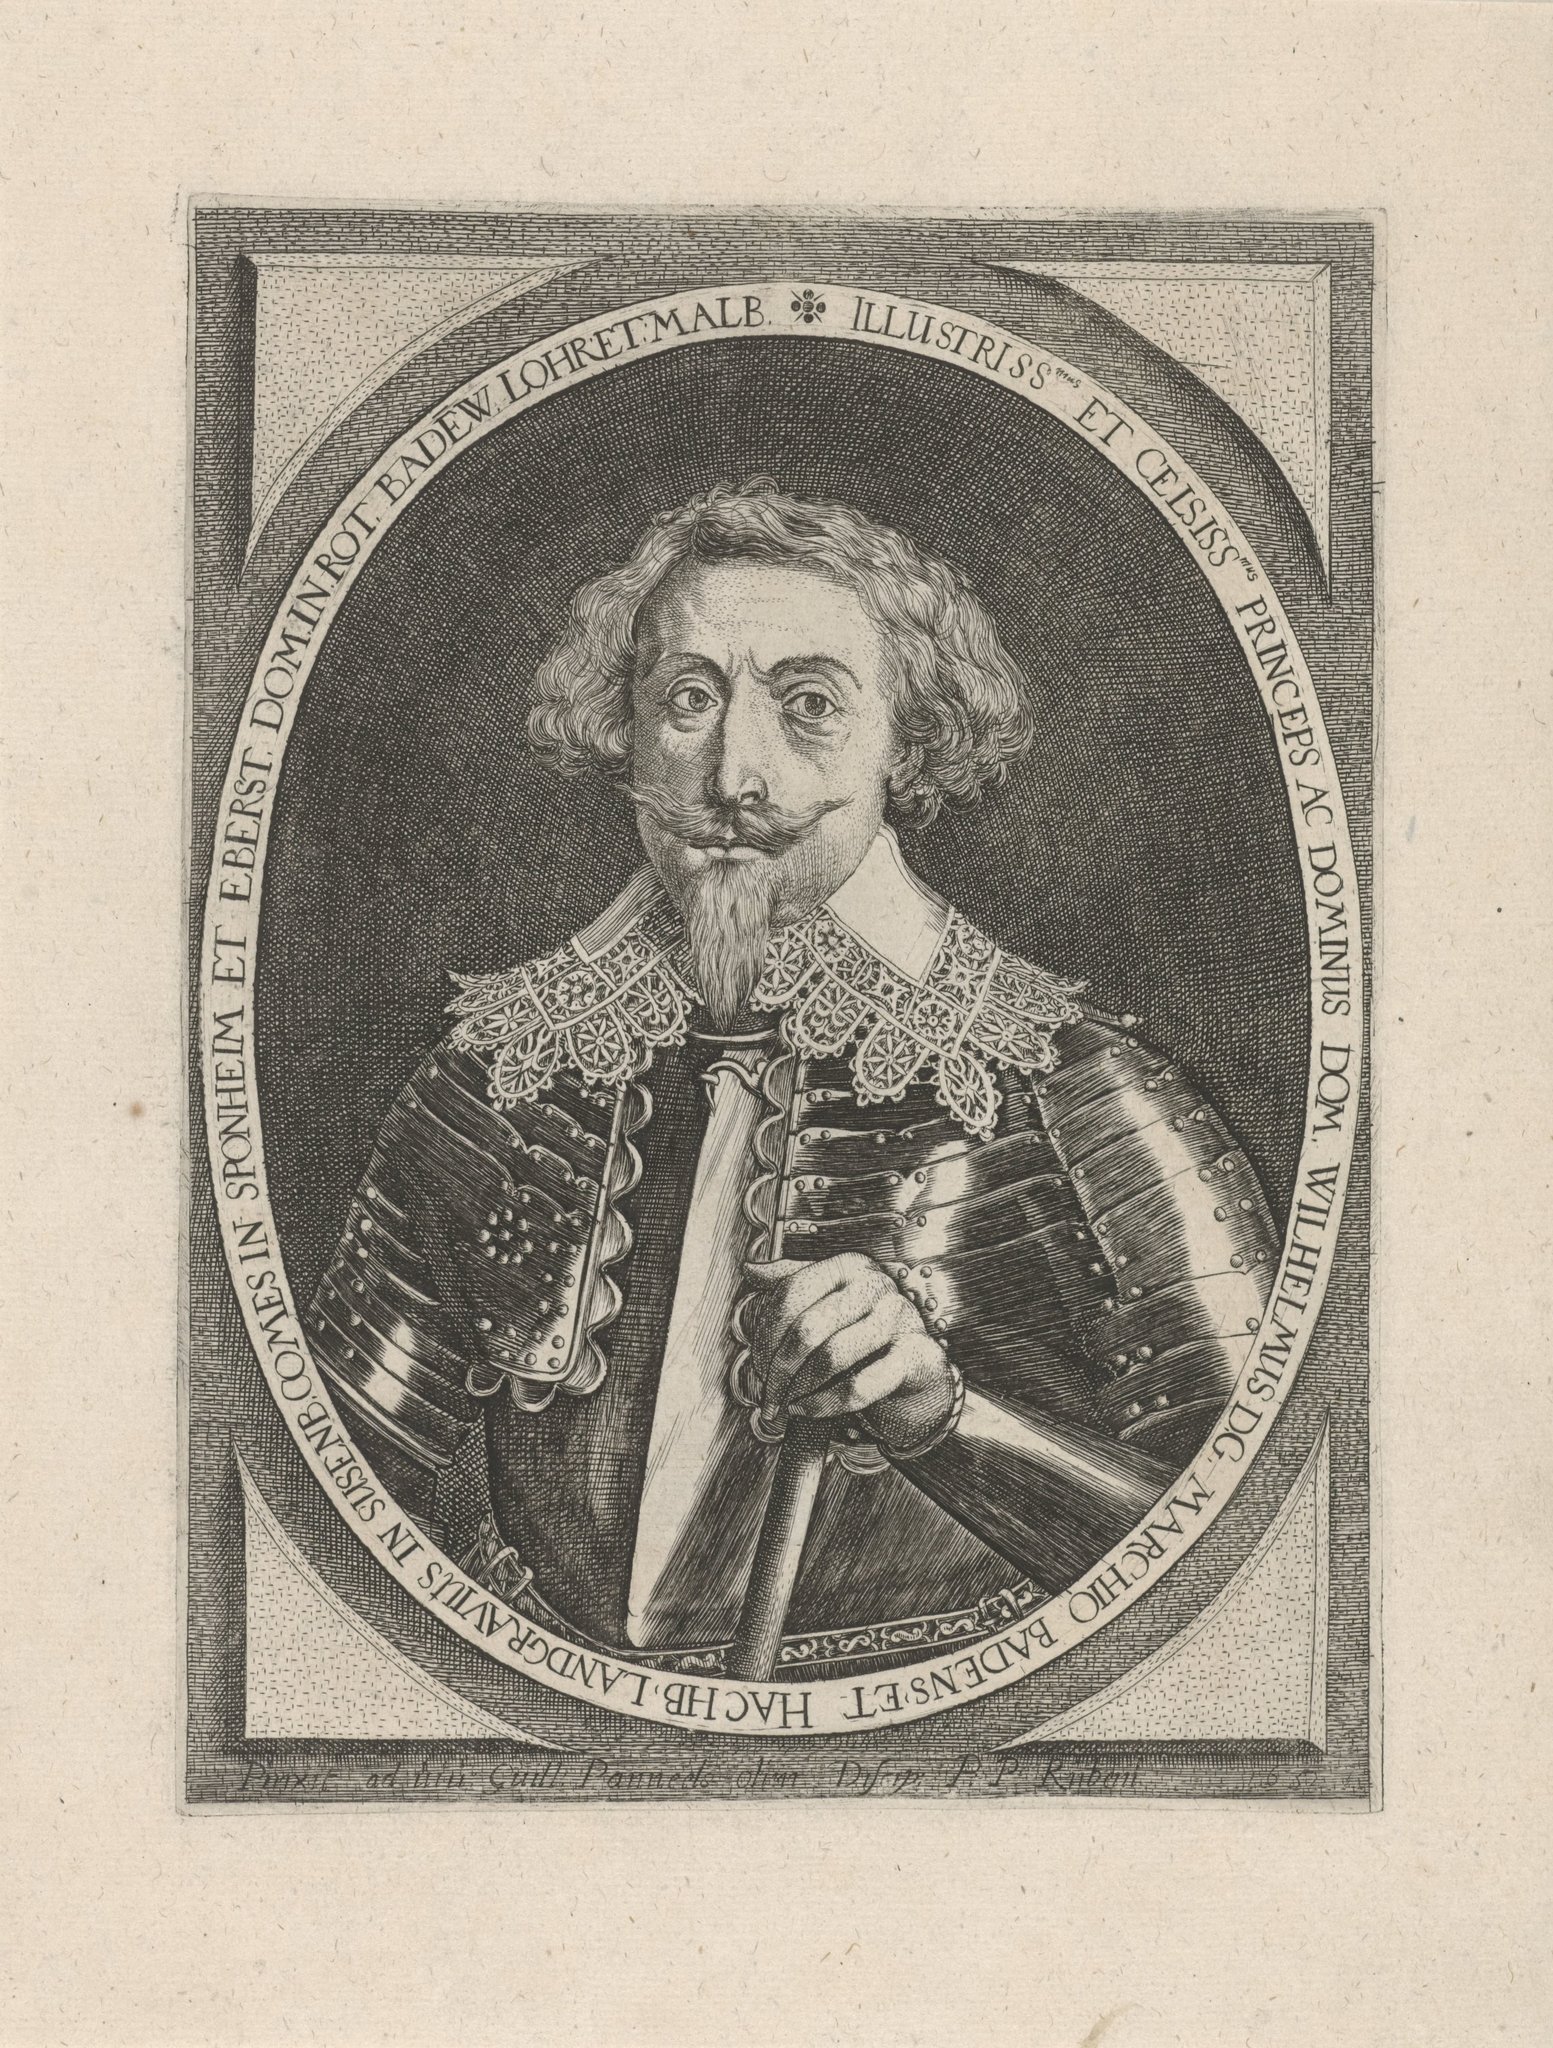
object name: print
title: Portret van Willem, markgraaf van Baden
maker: willem panneels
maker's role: print maker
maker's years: 1600-1632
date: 1632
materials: paper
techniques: engraving, etching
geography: straatsburg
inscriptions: collector's mark: Lugt 2228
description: Busteportret van Willem, markgraaf van Baden, in harnas. Met zijn linkerhand steunt hij op een commandostaf. Het portret is gevat in een ovale omlijsting met vierkant randwerk en randschrift in het Latijn.